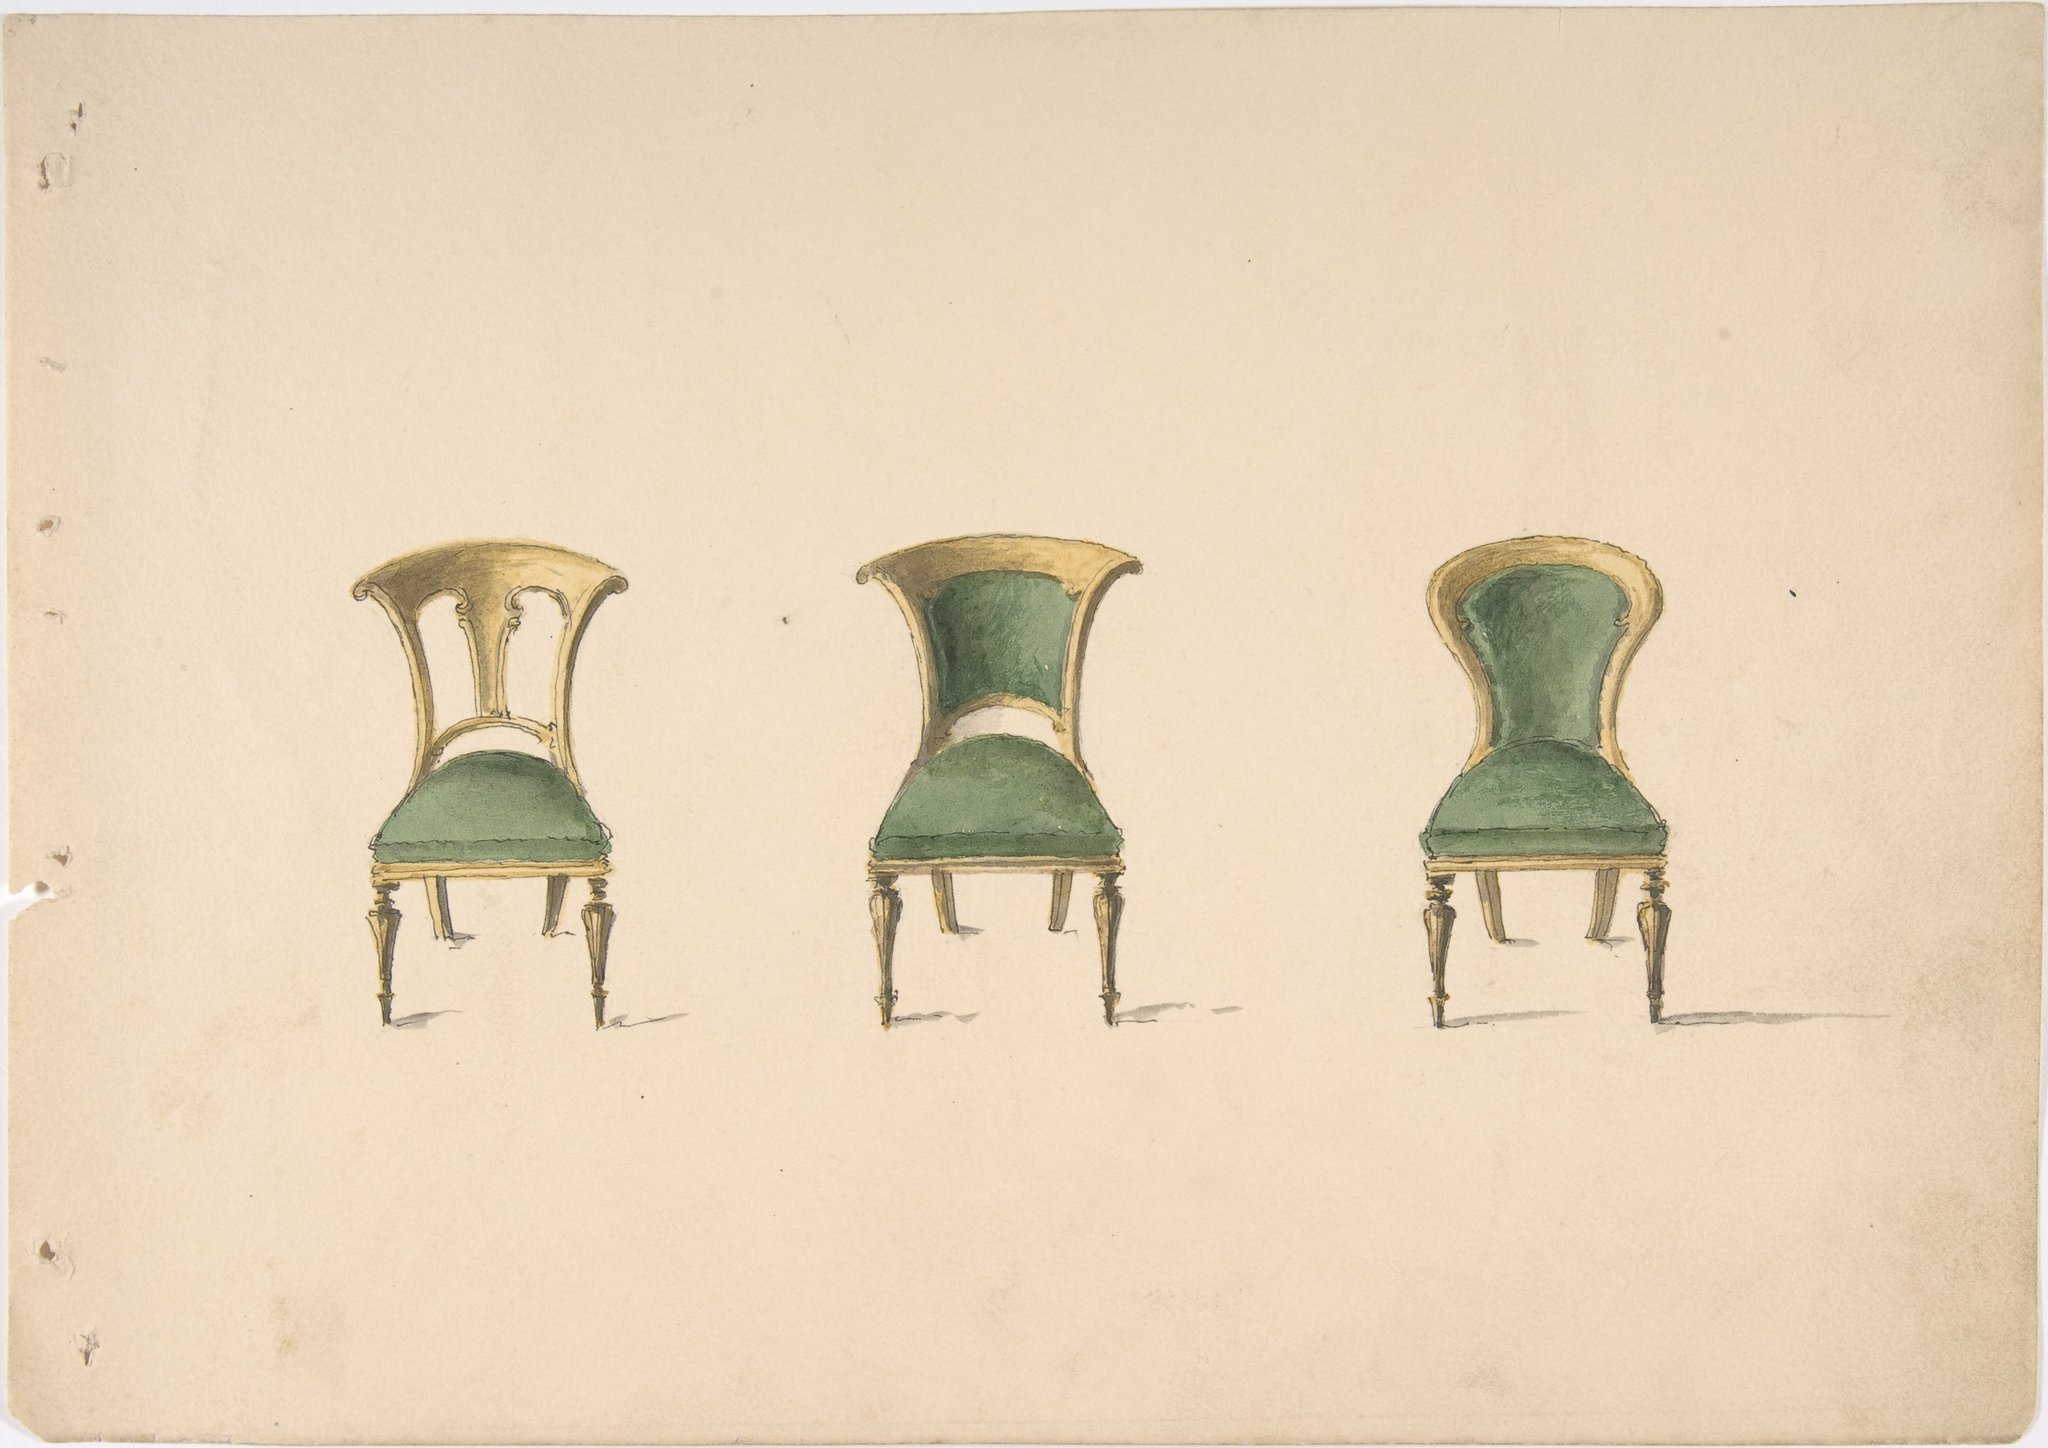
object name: drawing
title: Design for Three Chairs with Green Upholstery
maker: anonymous, british, 19th century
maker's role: artist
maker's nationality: british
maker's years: 1800-1900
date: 1801-1833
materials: ink, watercolor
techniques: brush, pen, wash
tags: chairs